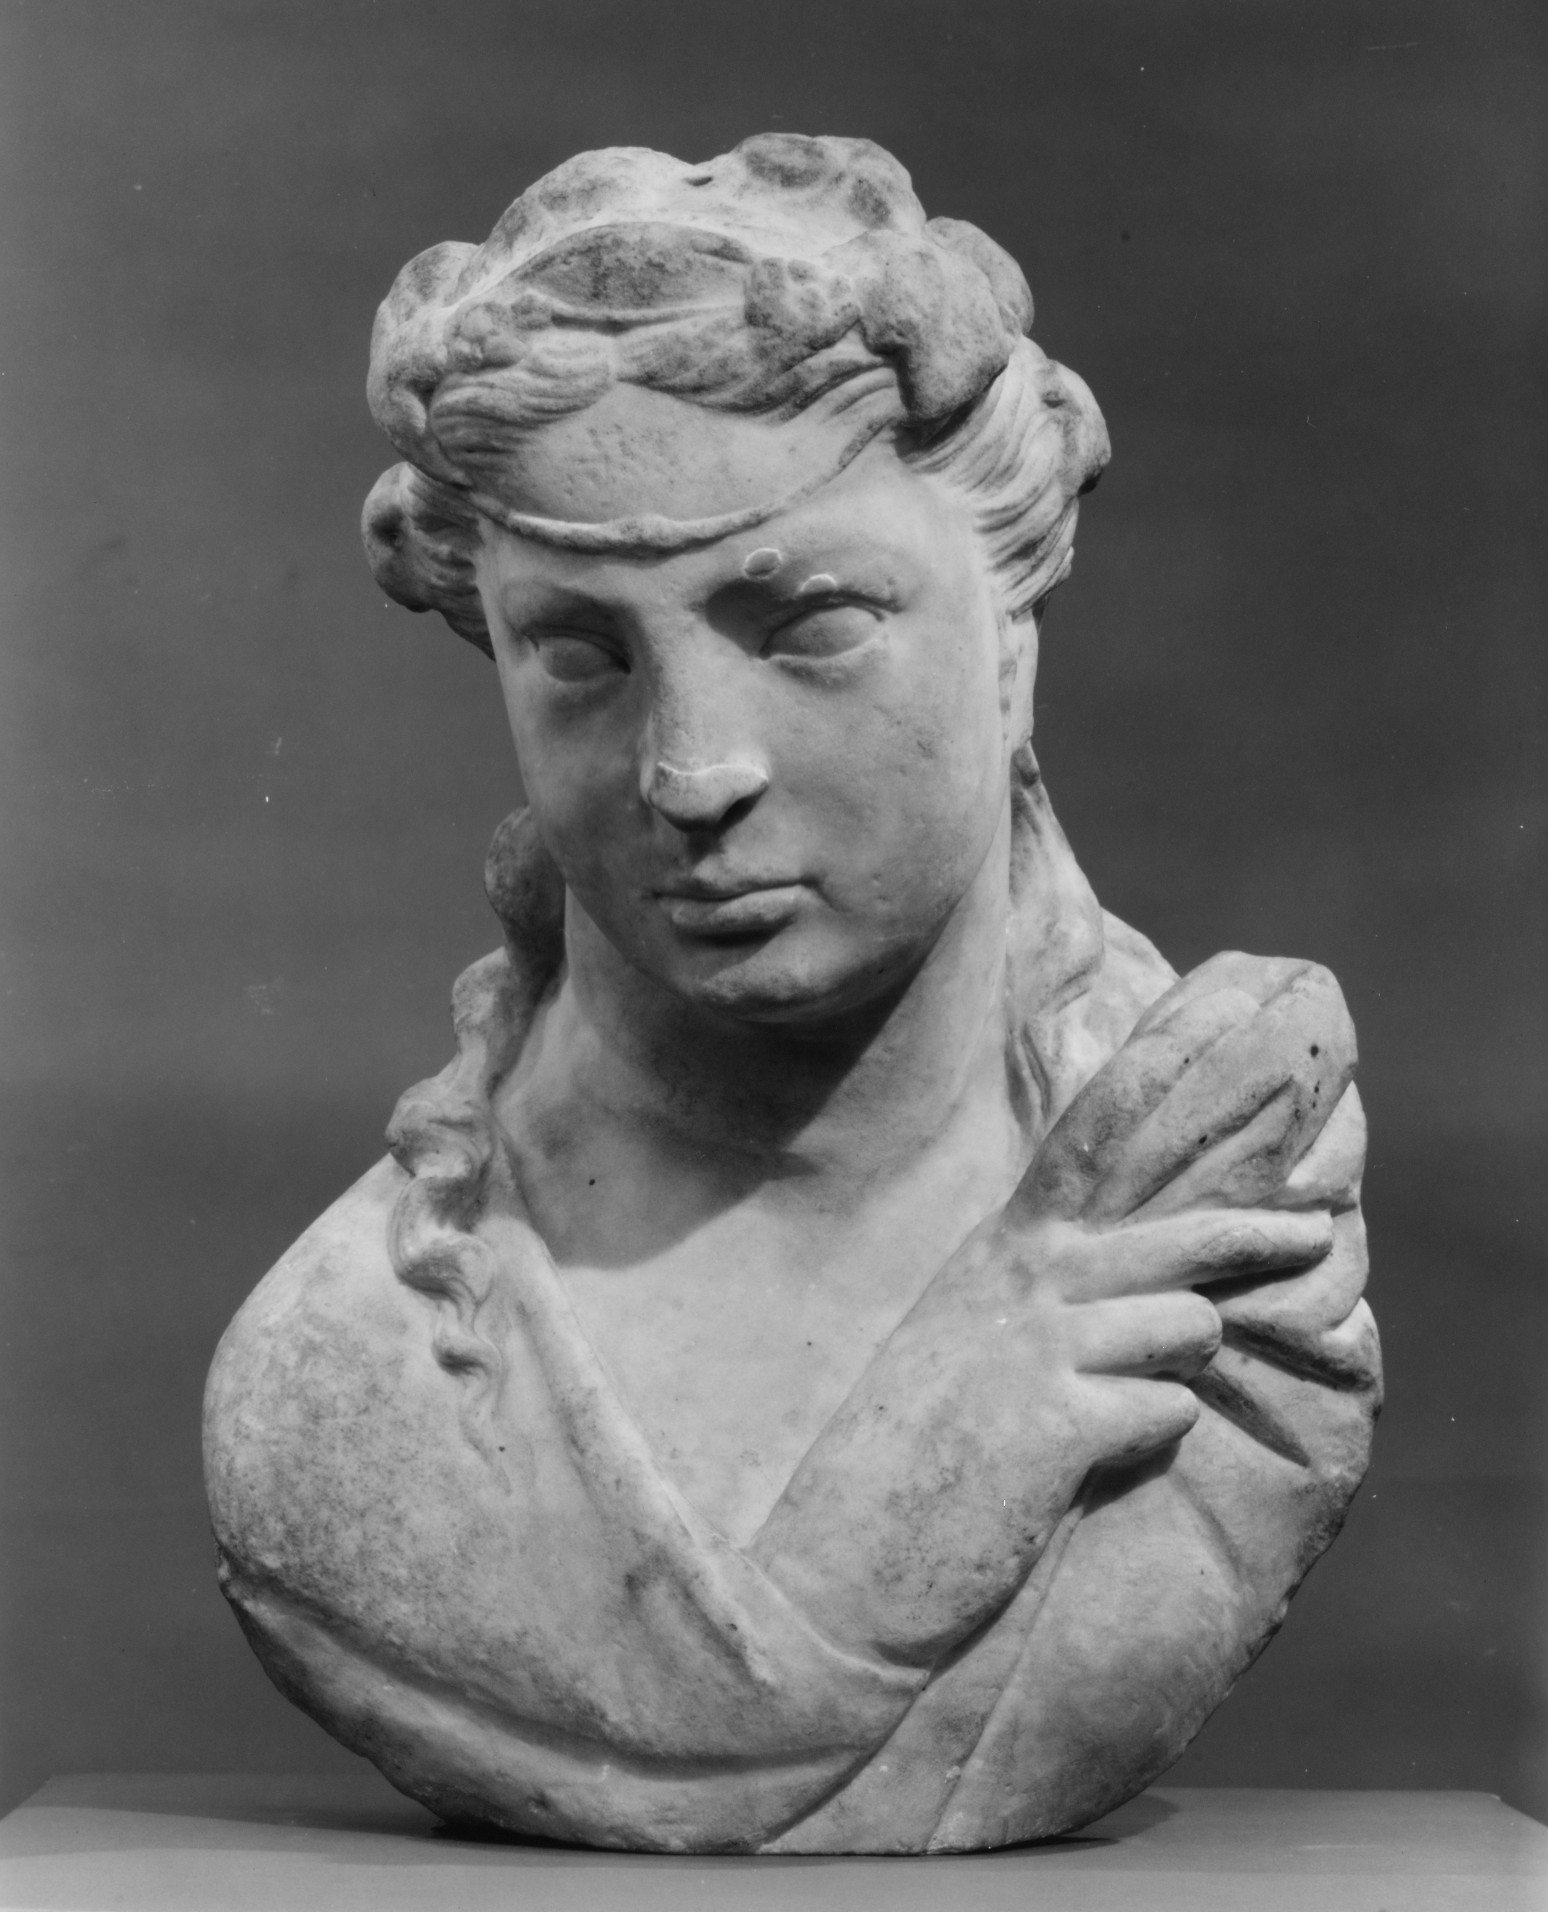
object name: bust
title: A Woman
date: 1301-1800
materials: marble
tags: portraits,women